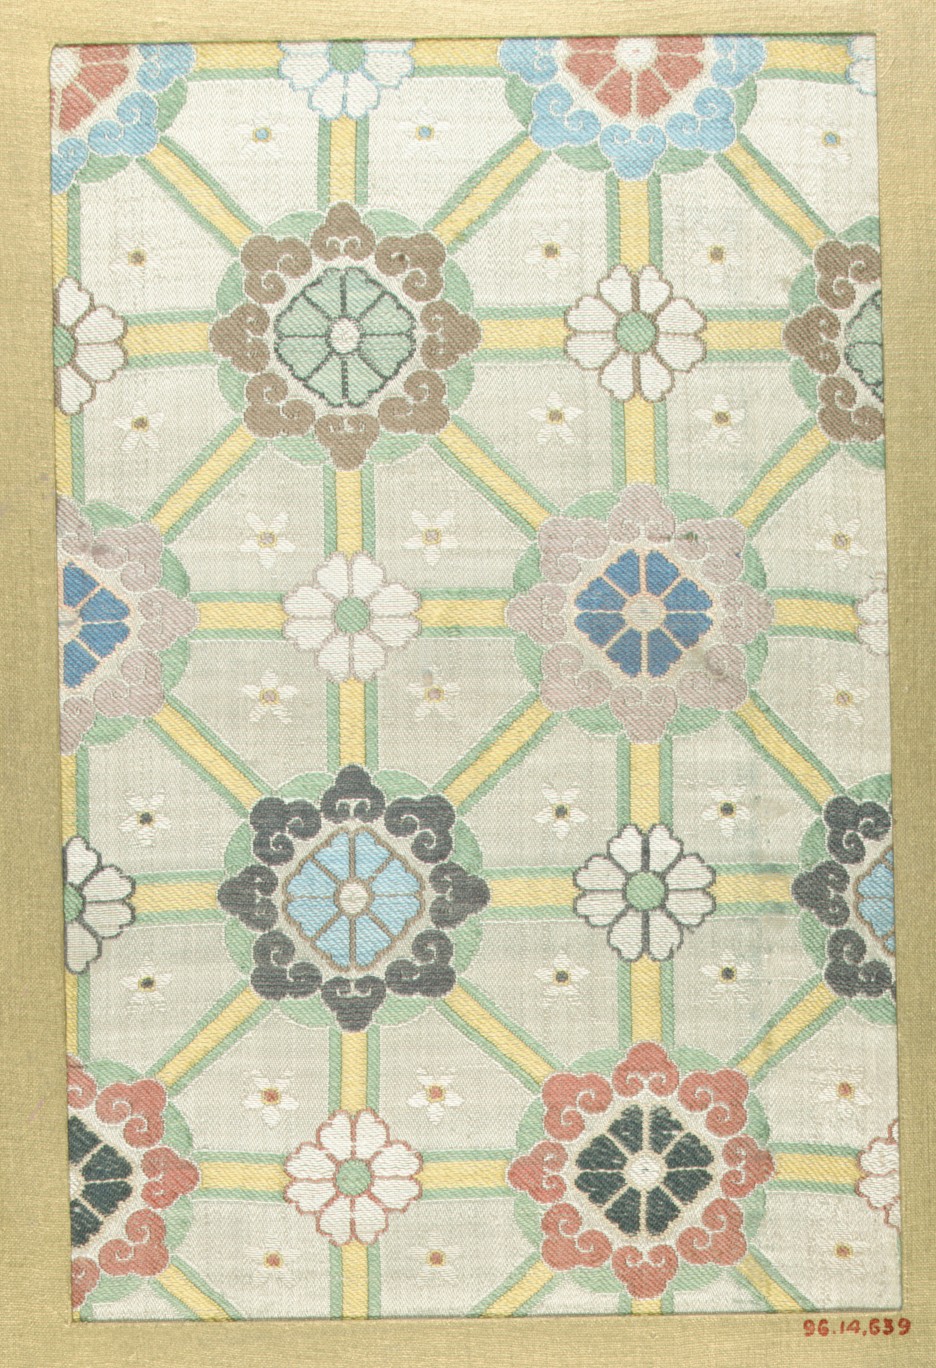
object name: piece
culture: japanese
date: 1701-1900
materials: silk